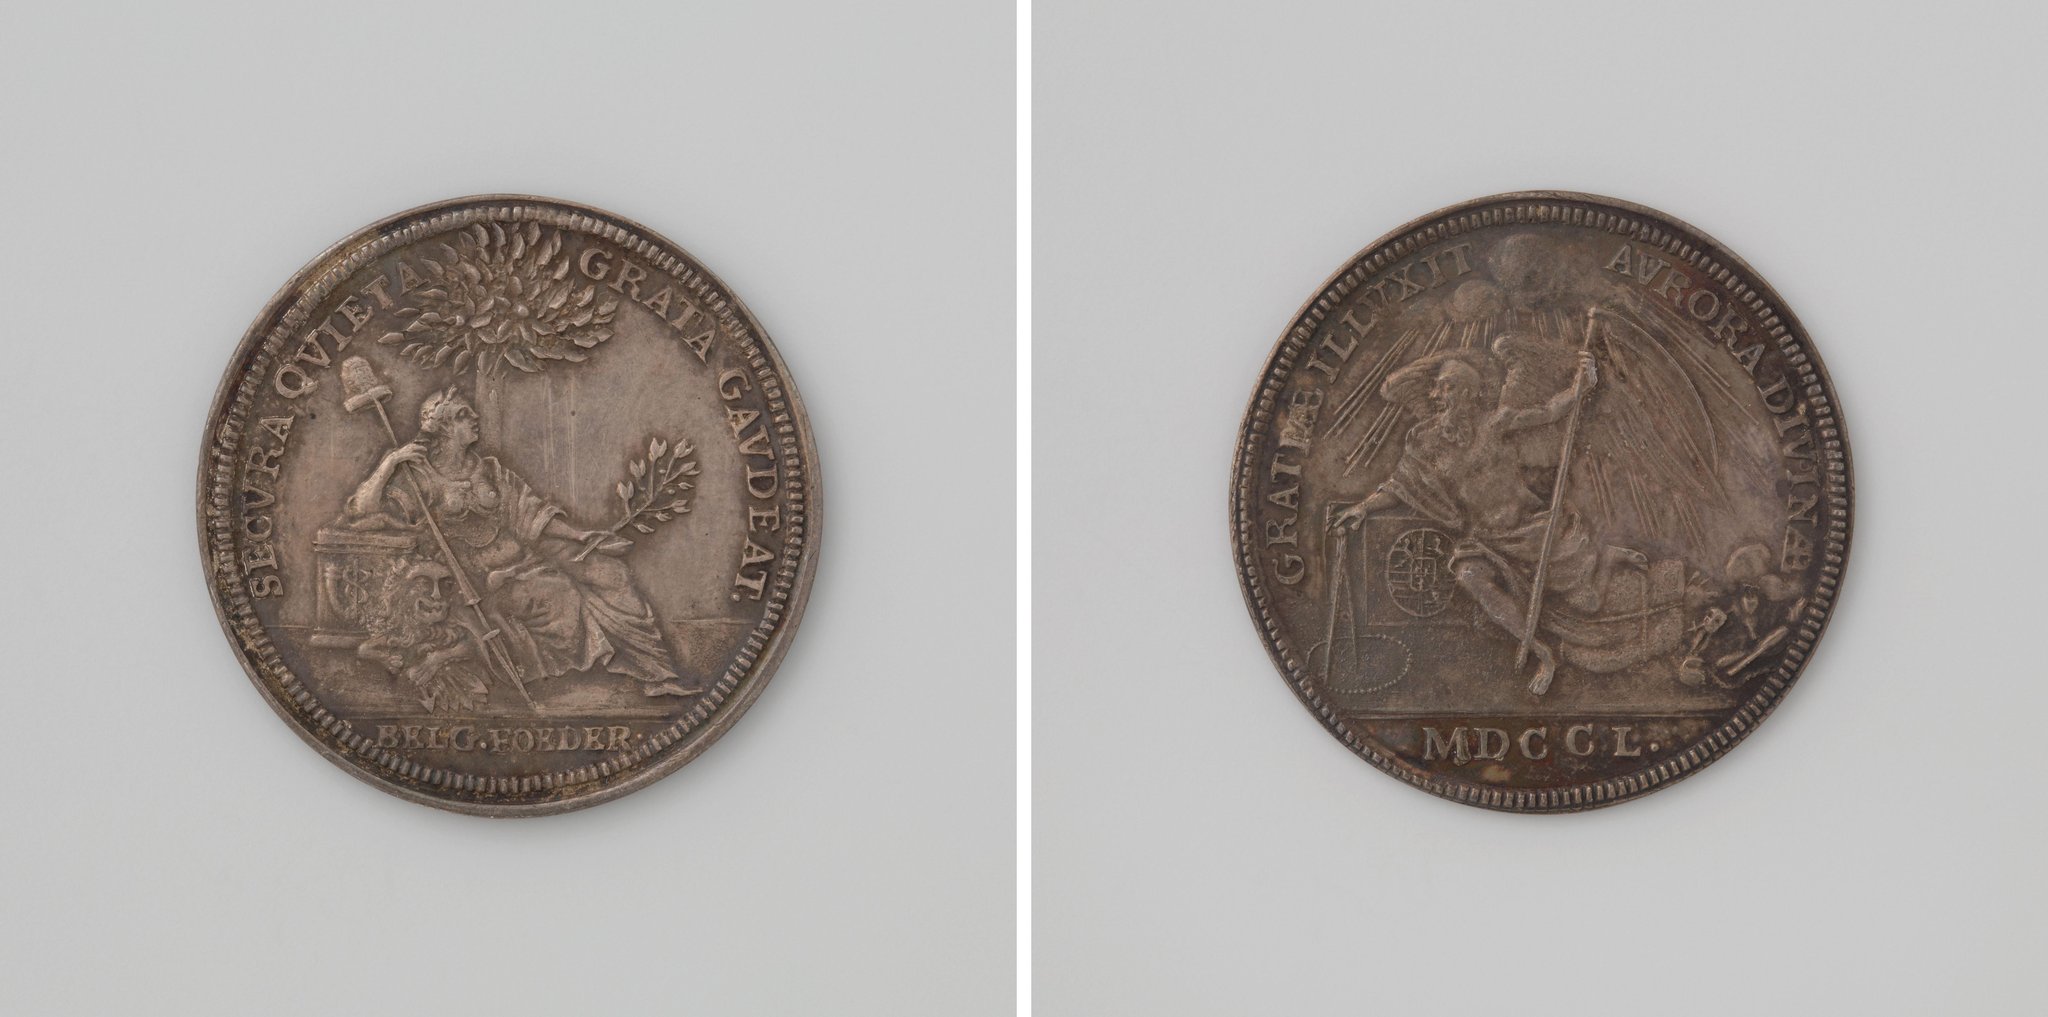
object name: new year medal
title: Aanvang van het jaar 1750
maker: johan george holtzhey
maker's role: mintmaster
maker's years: 1726-1808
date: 1750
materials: silver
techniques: striking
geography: amsterdam